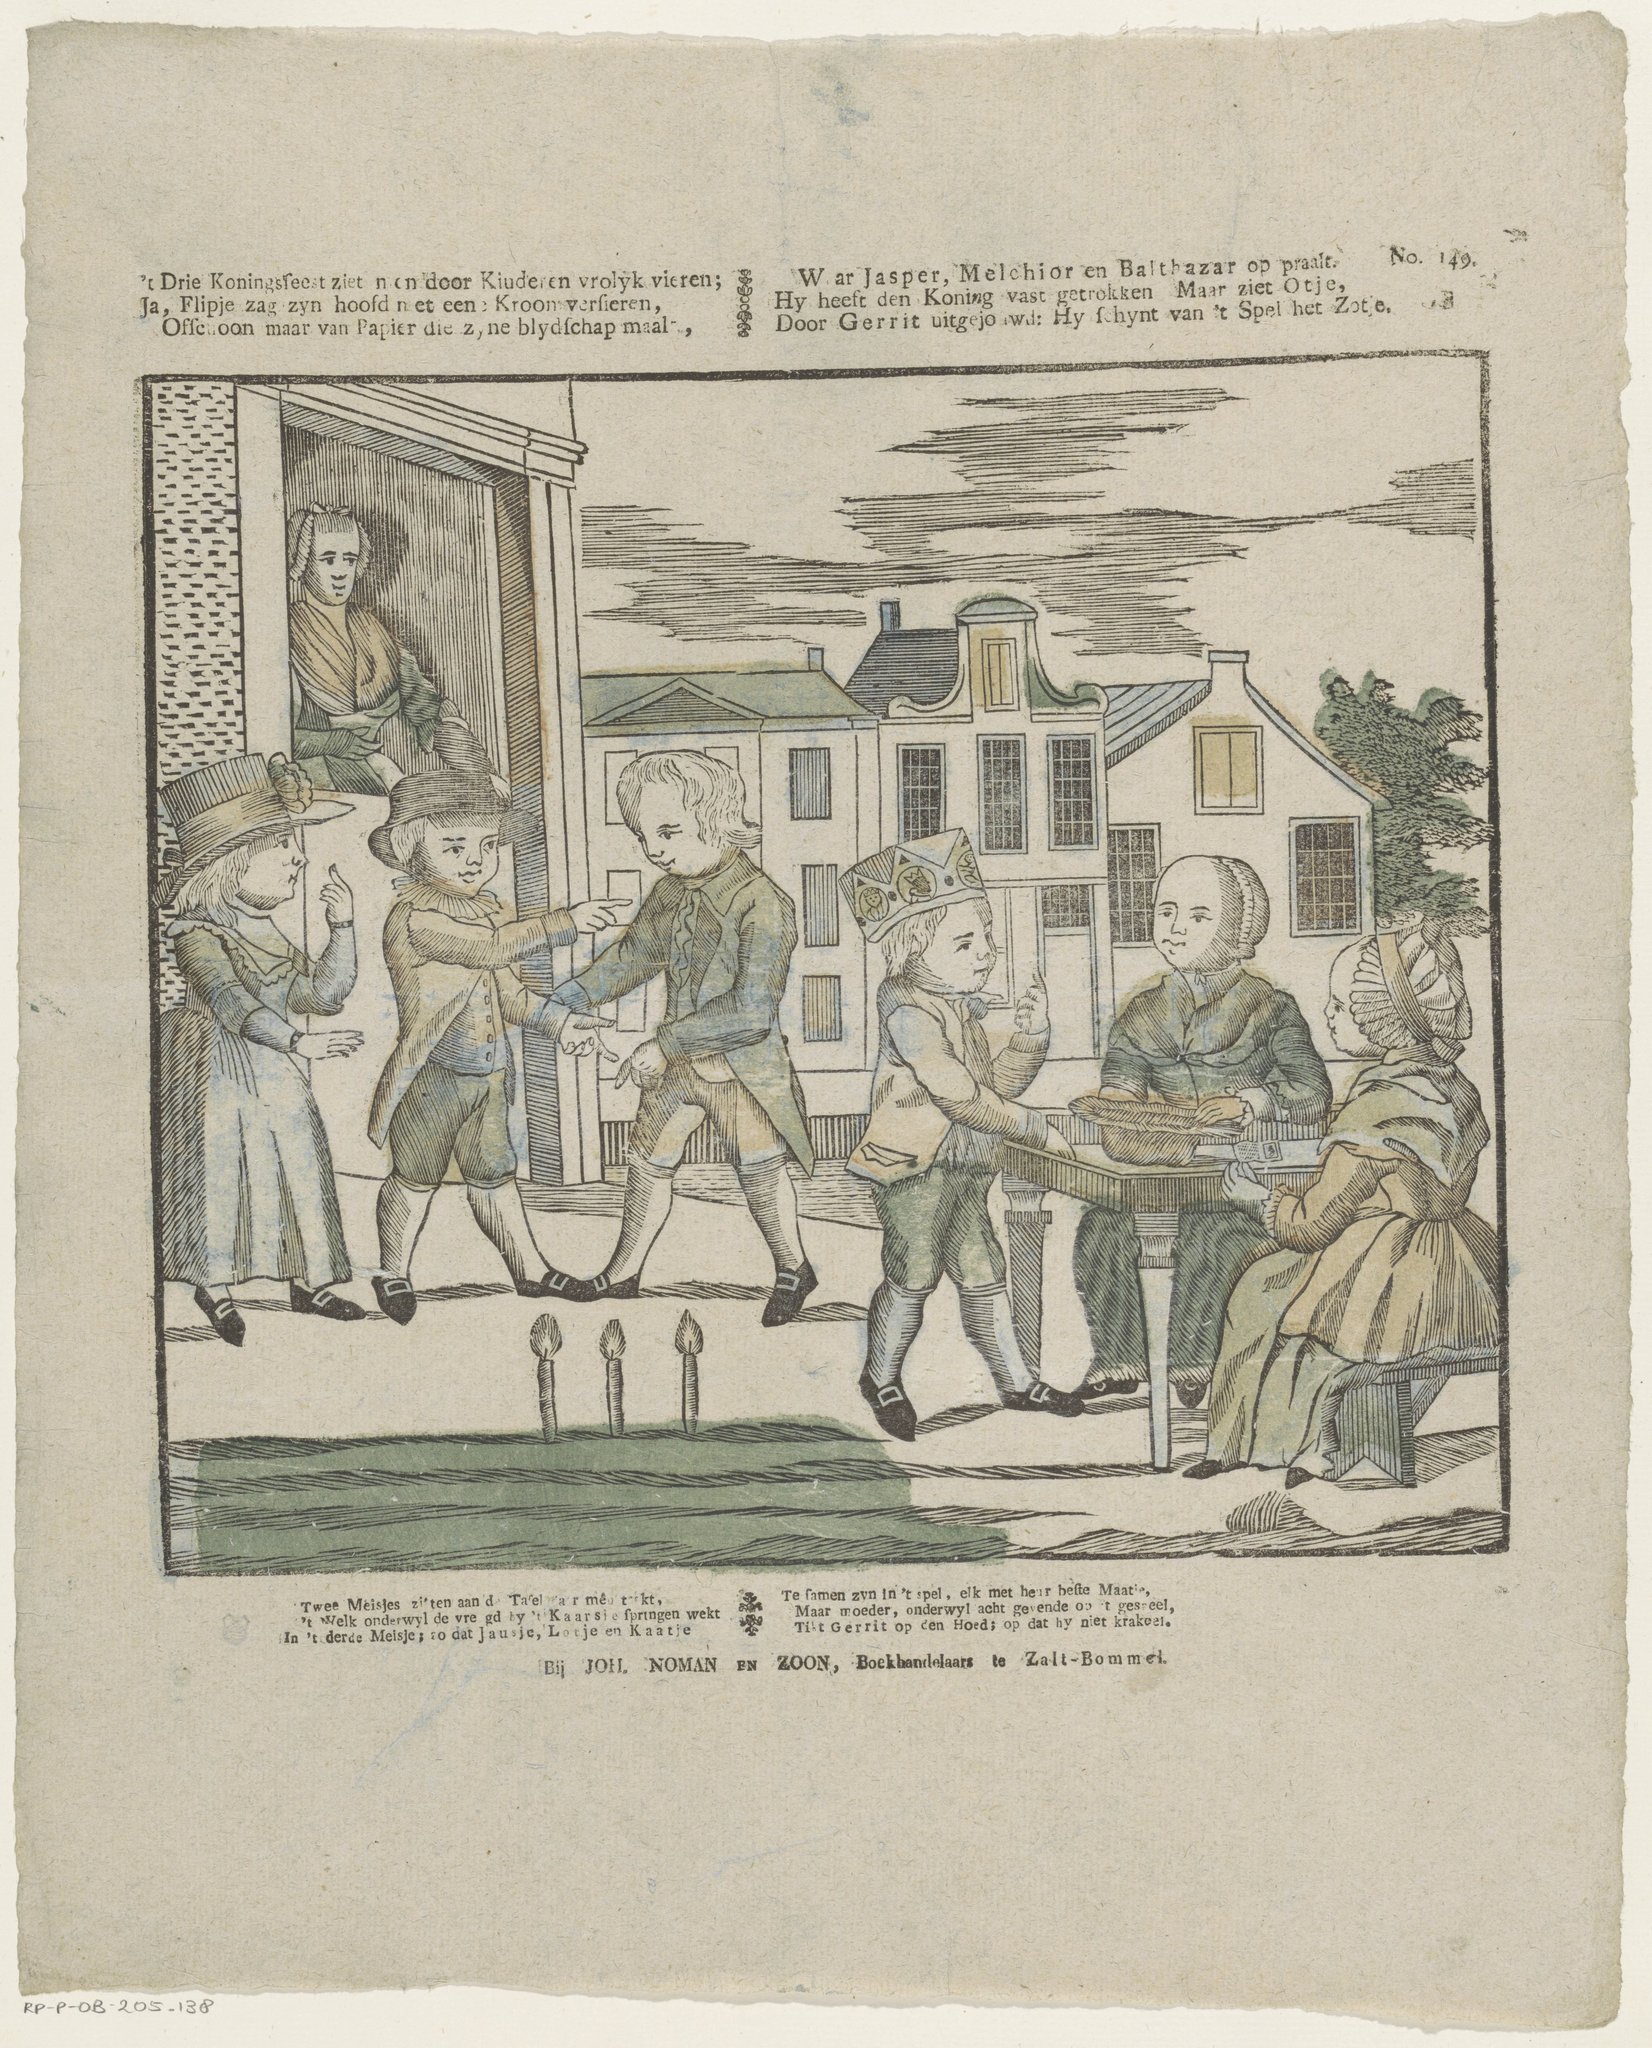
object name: print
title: 't Drie-koningsfeest ziet men door kindren vrolyk vieren; / Ja, Flipje zag zyn hoofd met eenen kroon versieren [(...)]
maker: Anonymous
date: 1830-1892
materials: paper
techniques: colour, letterpress printing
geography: netherlands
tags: children's games and plays, twelfth night, usually falling on the eve of january 6, royal household; courtiers, retinue, train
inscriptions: collector's mark: Lugt 2760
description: Blad met een grote voorstelling van zes kinderen die het spel koning-trekken spelen op het Driekoningenfeest. Moeder kijkt vanaf een afstandje toe. Onder de afbeelding een zesregelig vers in twee kolommen. Genummerd rechtsboven: No 149.